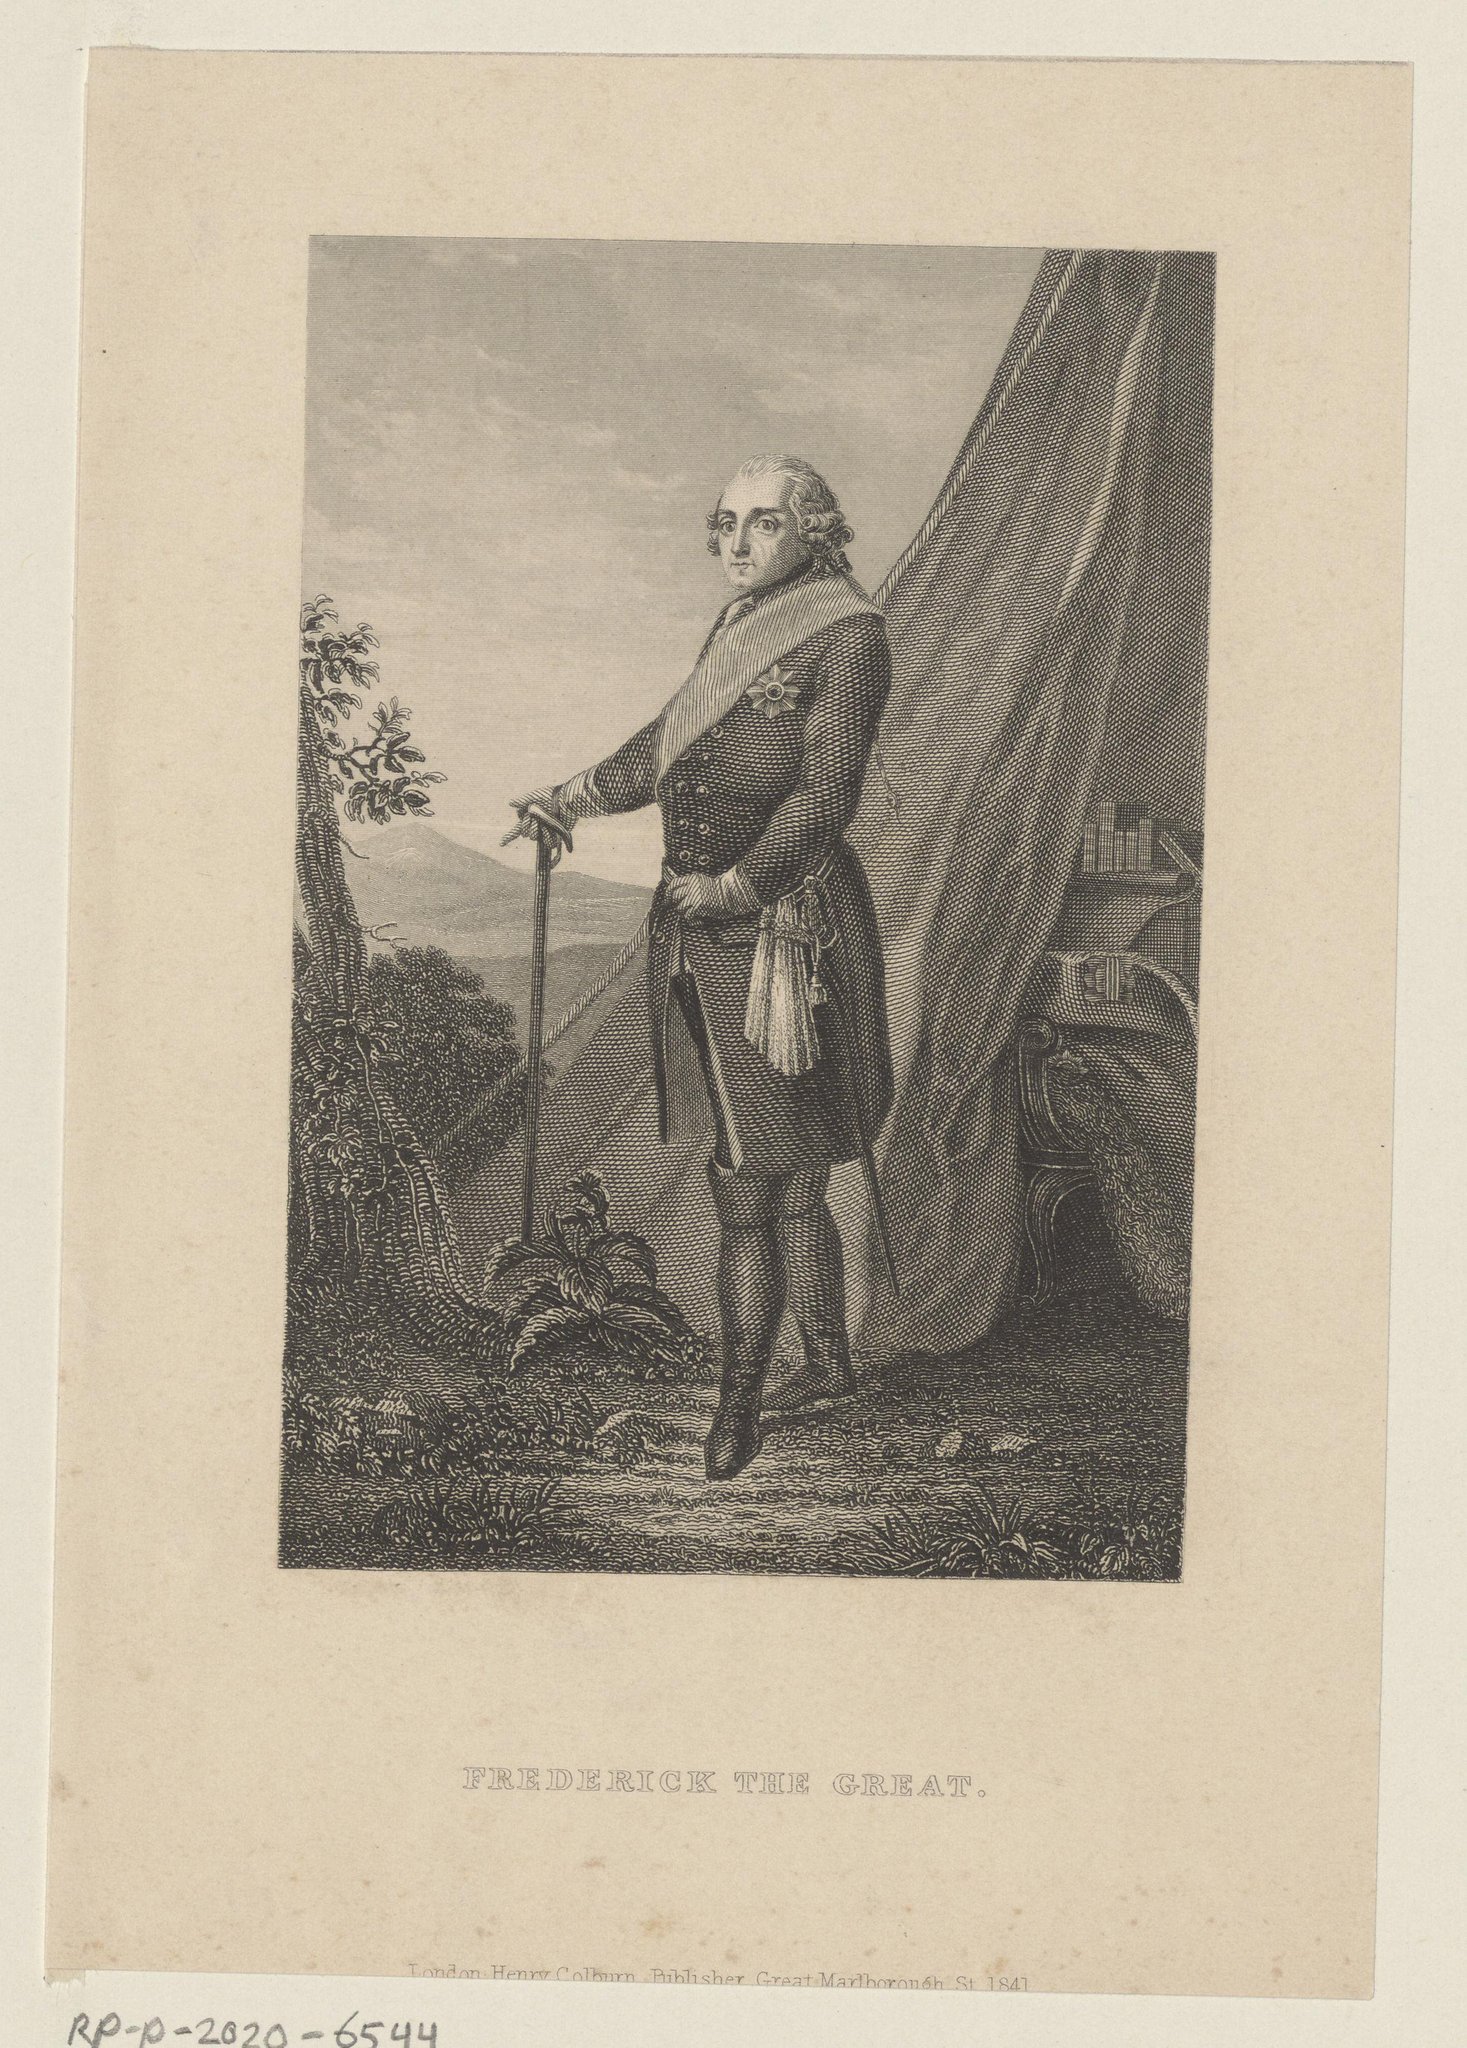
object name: print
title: Portret van Frederik de Grote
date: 1820-1855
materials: paper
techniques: etching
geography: england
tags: berlin, frederick ii (king of prussia), (military) camp with tents, historical persons, king